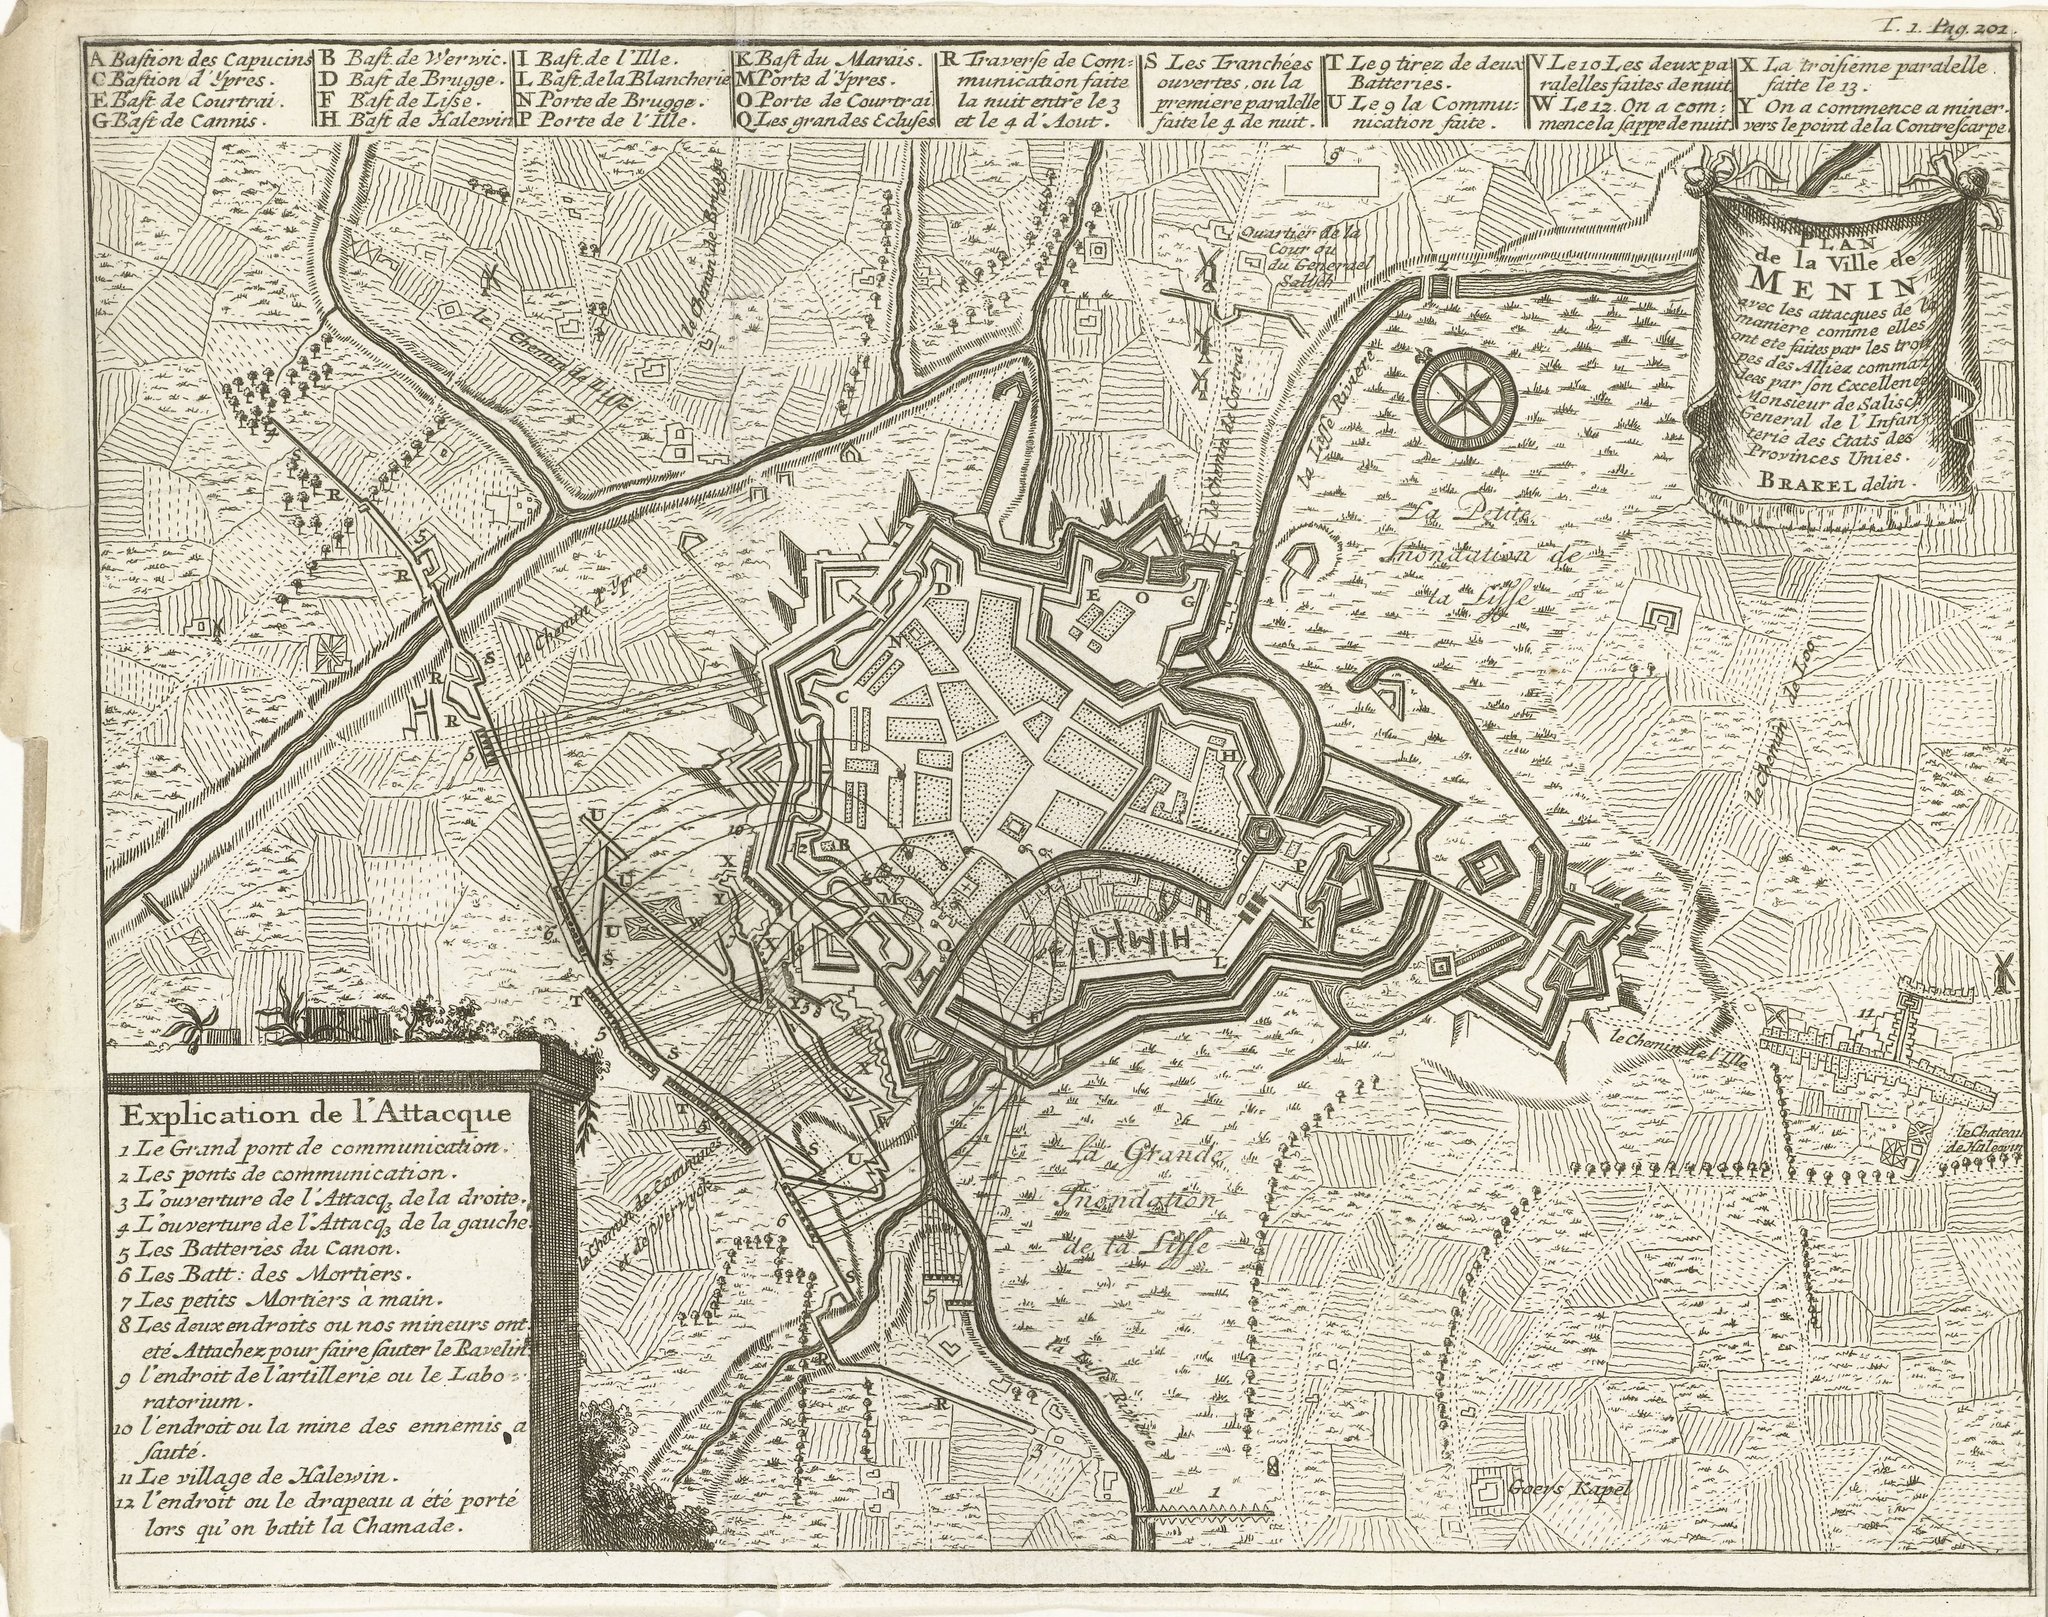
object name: print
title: Beleg van Menen, 1706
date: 1714-1716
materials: paper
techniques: etching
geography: northern netherlands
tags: johan willem friso (prins van oranje-nassau), siege, position war, maps of cities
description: Kaart met het beleg van Menen door de Geallieerden, 1706. Illustratie in de Nederlandse vertaling uit 1716 van J. Lamigue, Het leven van Zyne Hoogheit Johan Willem Friso, dl. I, p. 200/201.